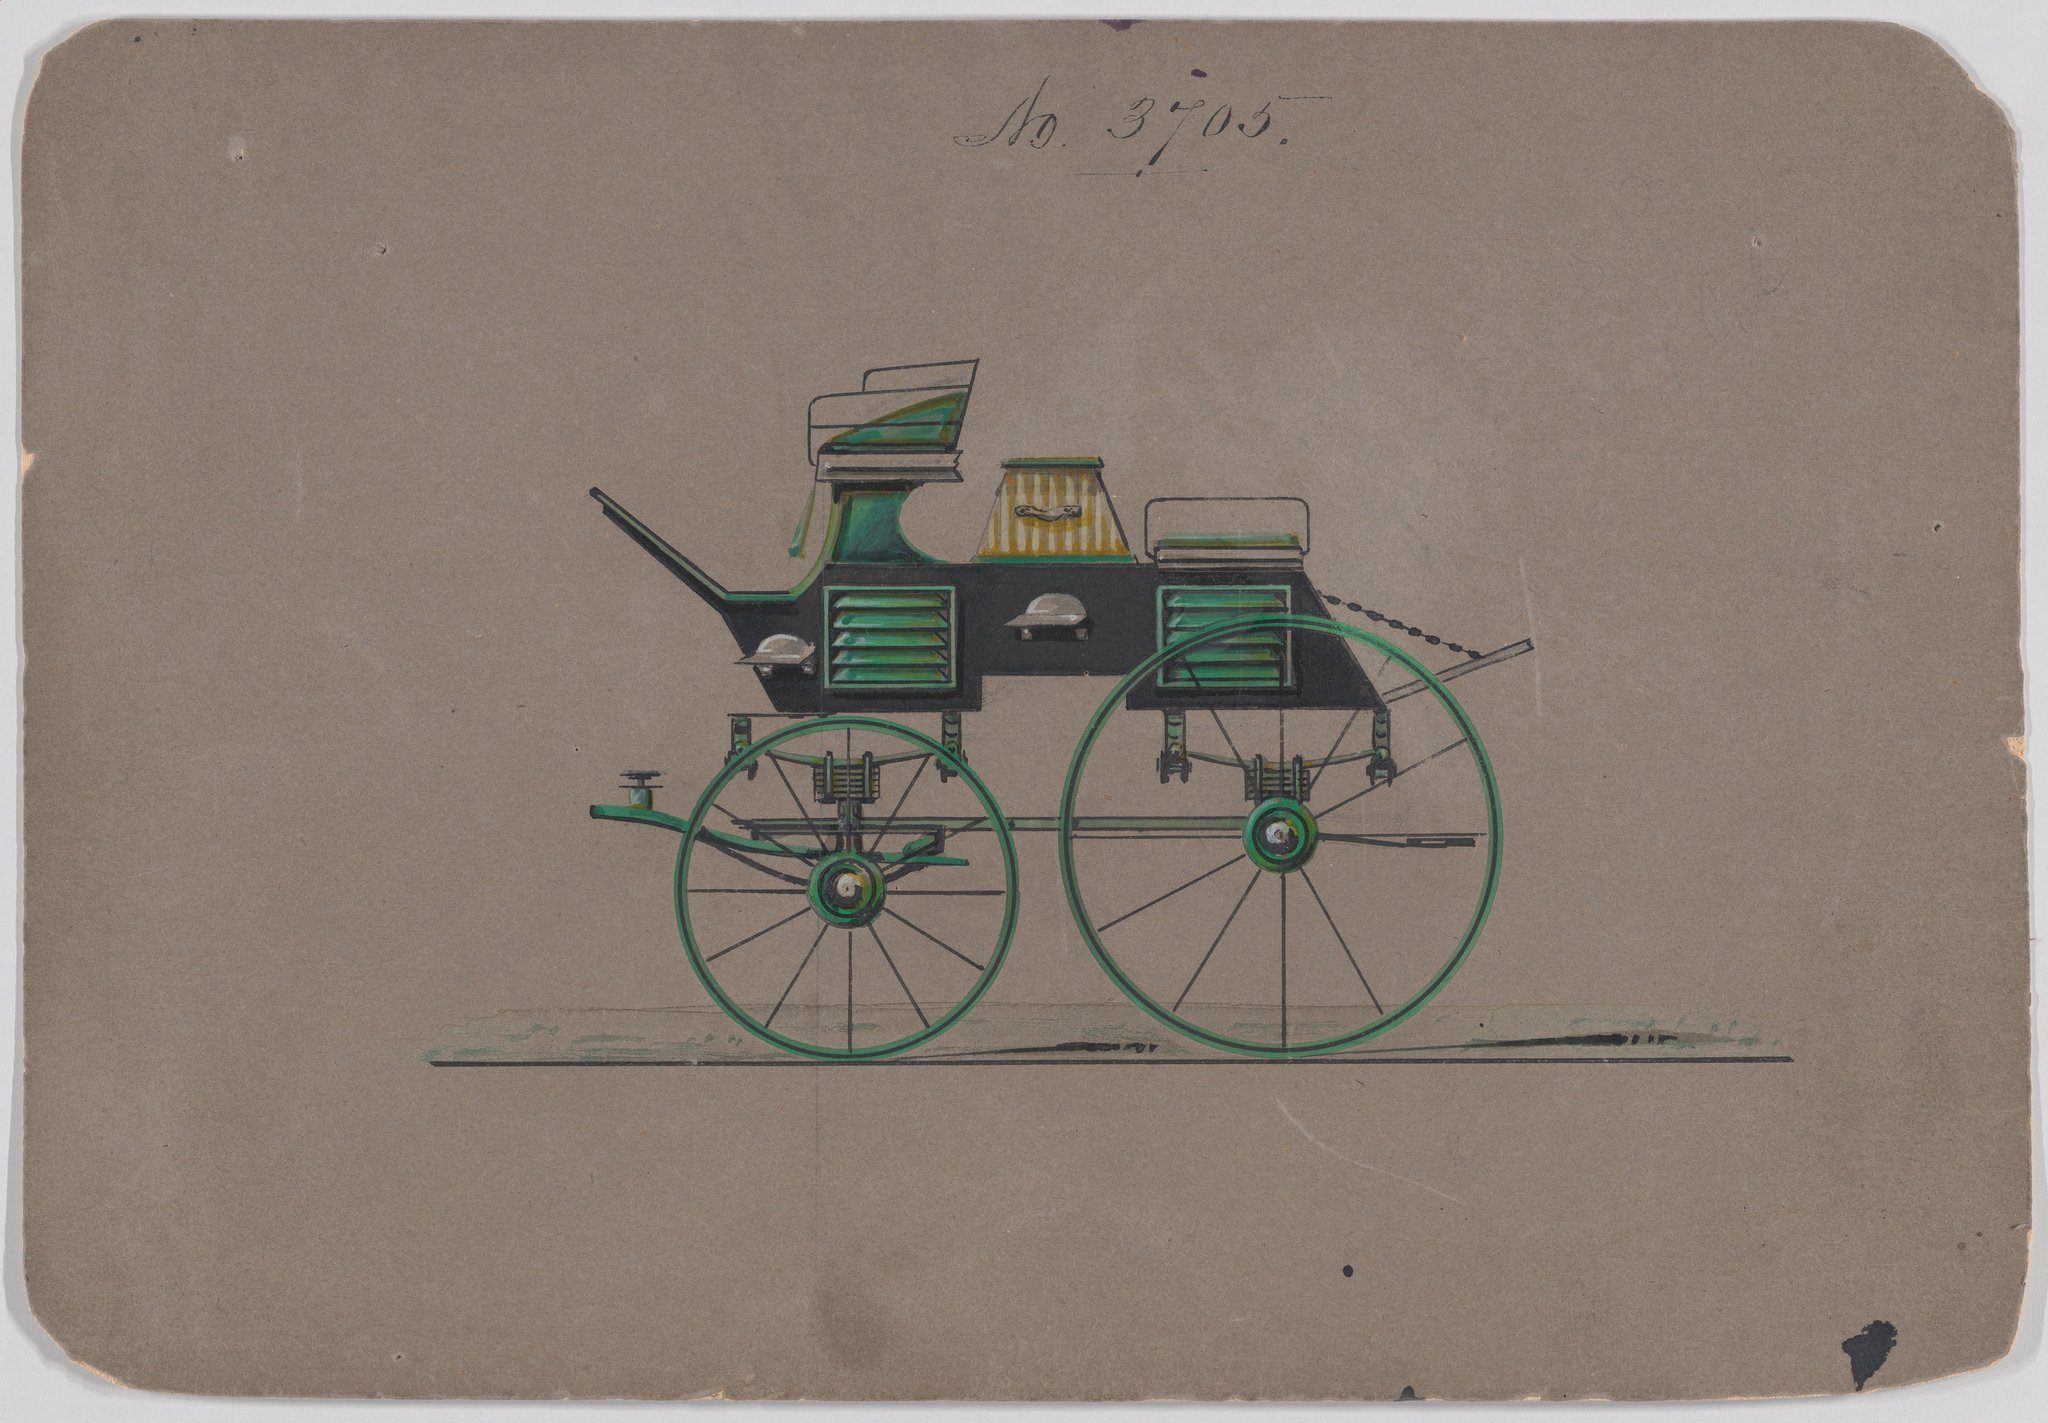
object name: drawing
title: Four Wheel Dog Cart .# 3705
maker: brewster & co.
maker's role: manufacturer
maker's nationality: american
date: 1881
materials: gouache, gum arabic, ink, watercolor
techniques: pen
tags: carriages